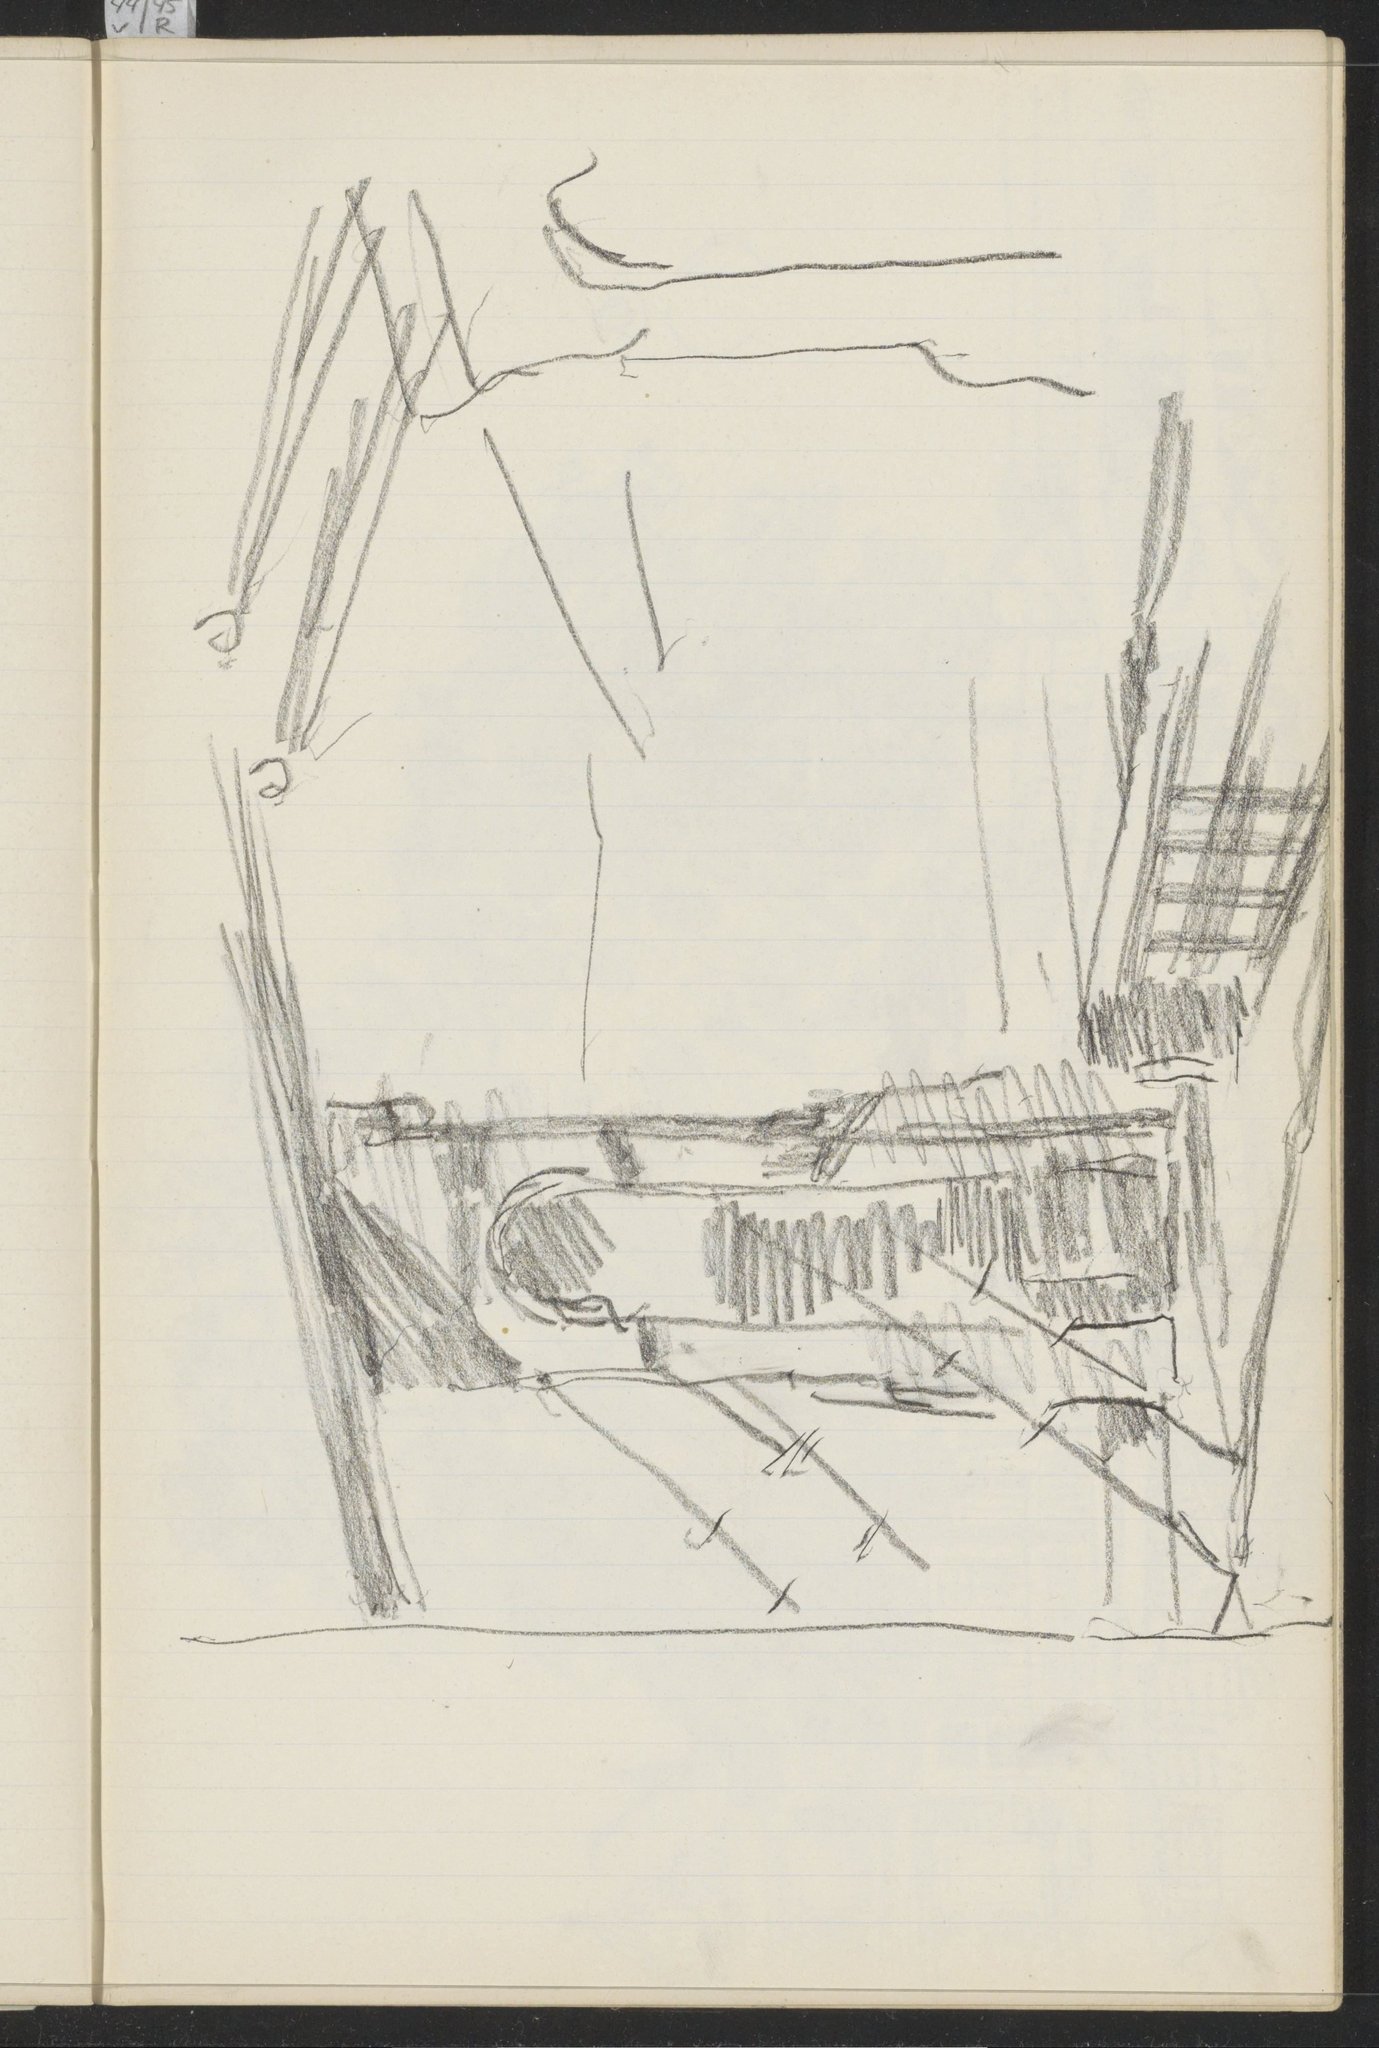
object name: sketchbook leaf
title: Ophaalbrug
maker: willem bastiaan tholen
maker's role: draughtsman, painter, print maker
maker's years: 1860-1931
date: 1900-1931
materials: chalk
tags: drawbridge ~ fortified city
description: Blad 42 recto uit een schetsboek met 55 bladen.